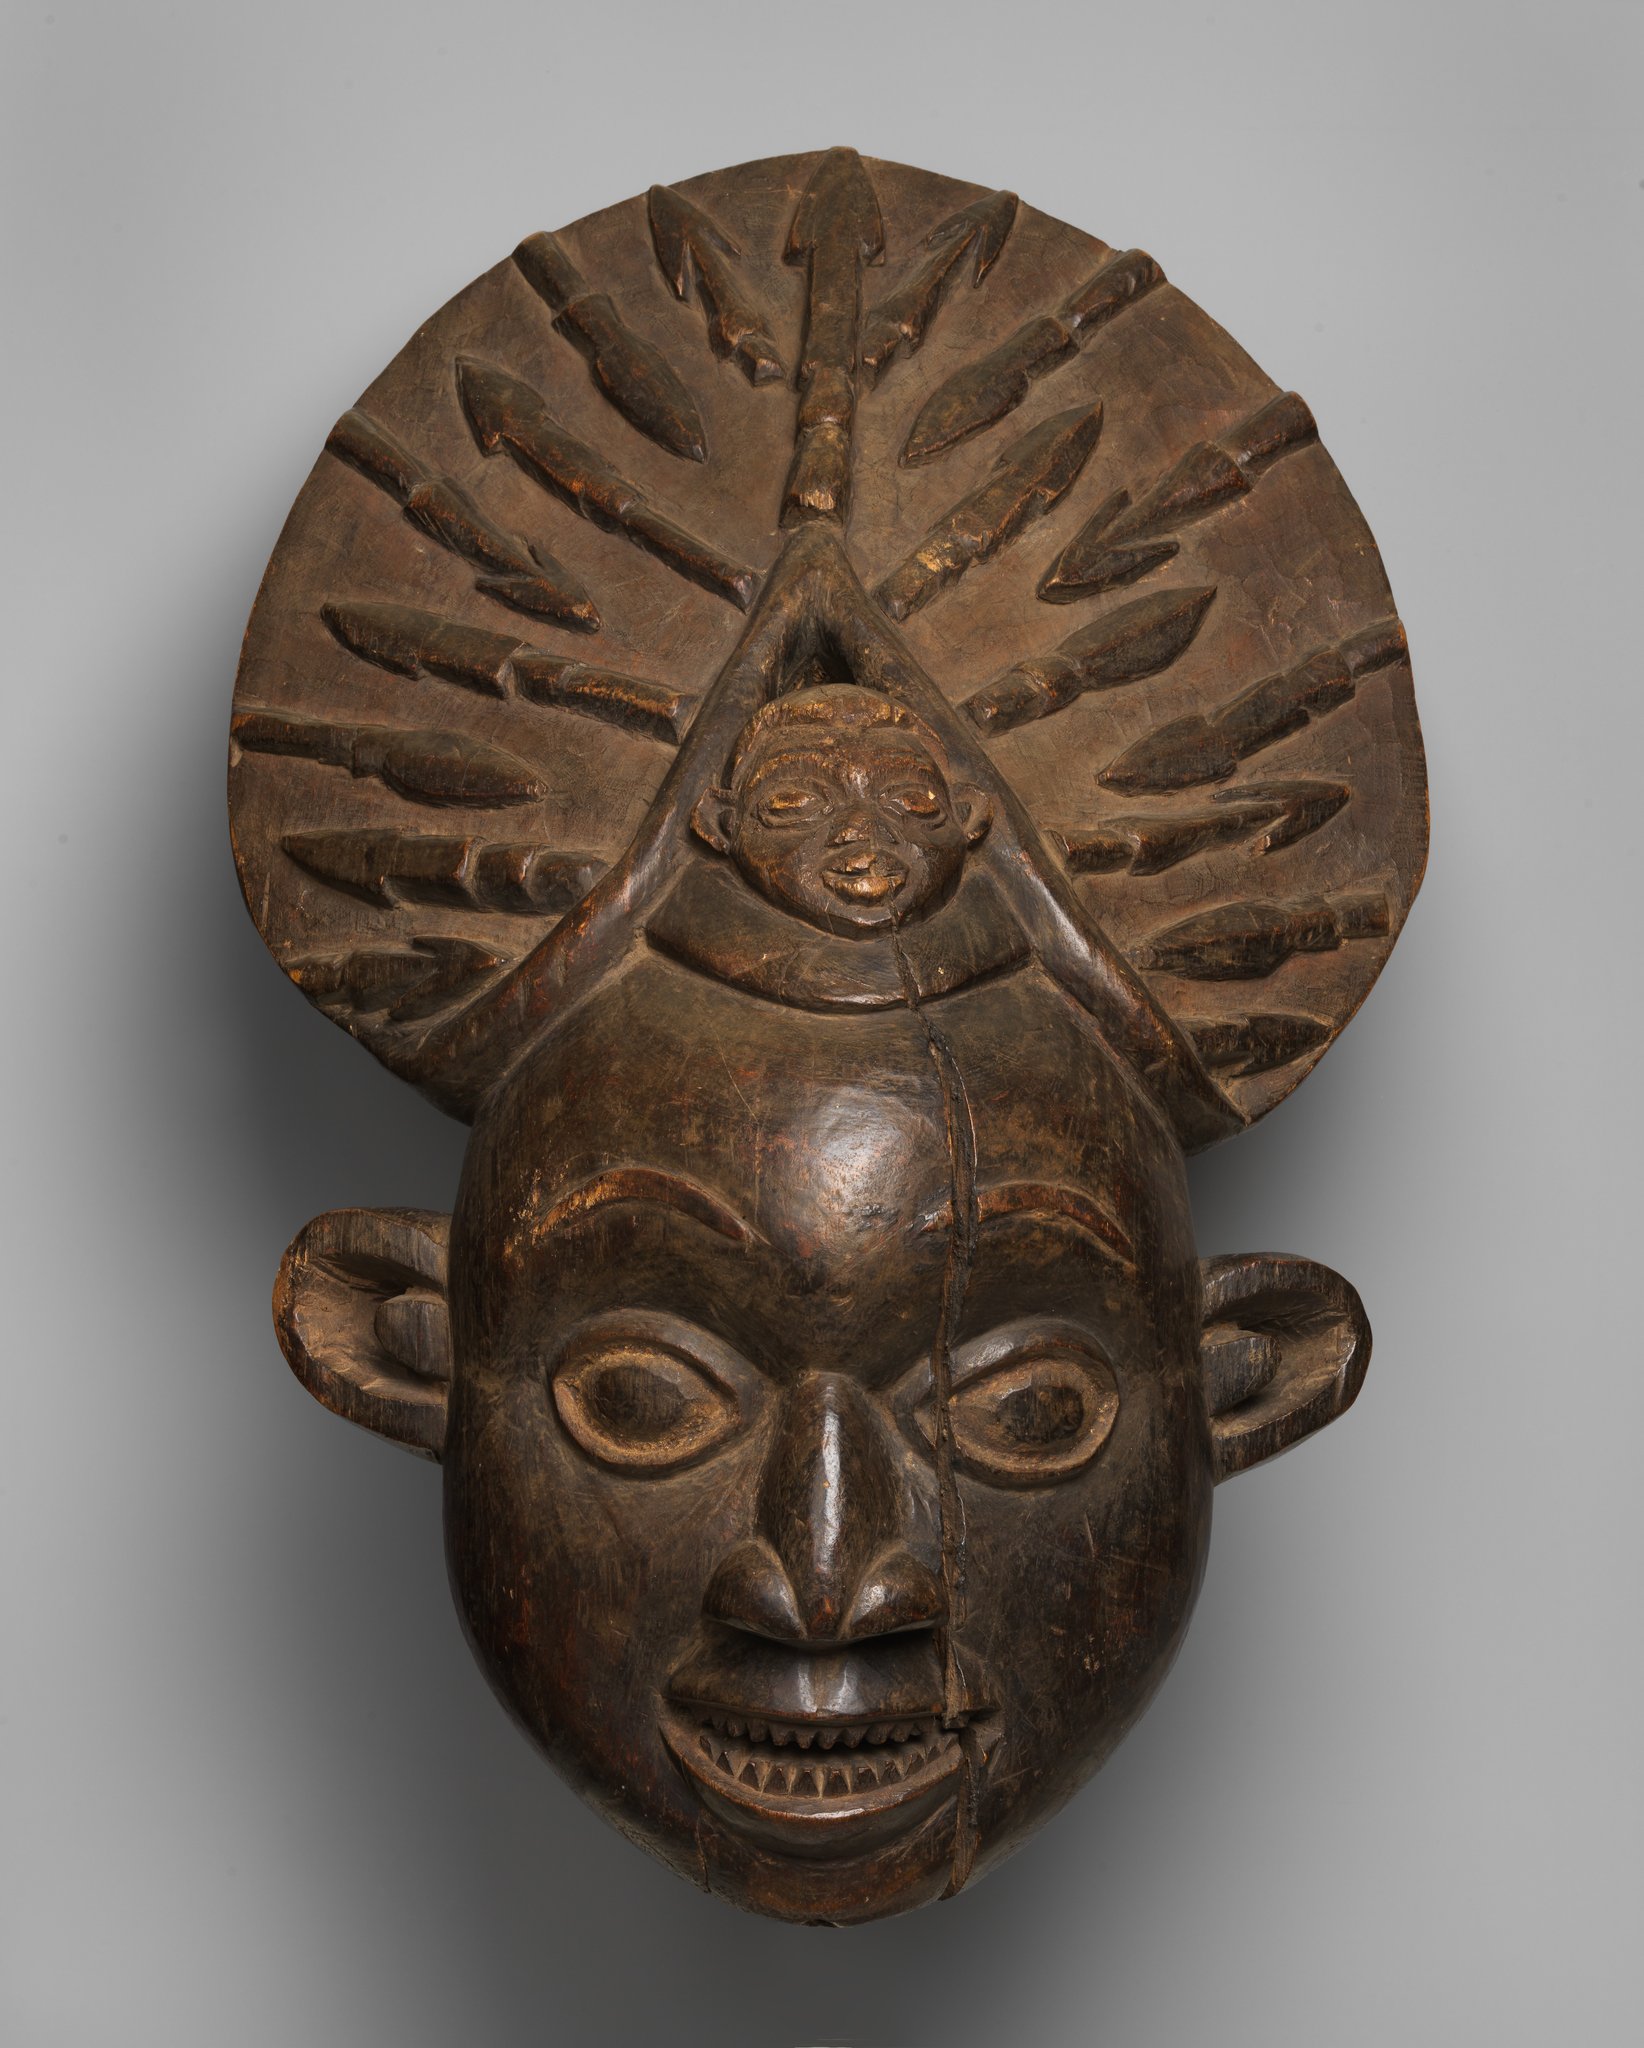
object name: mask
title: Helmet crest from a Ngumba/Kwifon masquerade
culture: kom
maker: grassfields artist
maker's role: artist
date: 1801-1900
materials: pigment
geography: cameroon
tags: spears